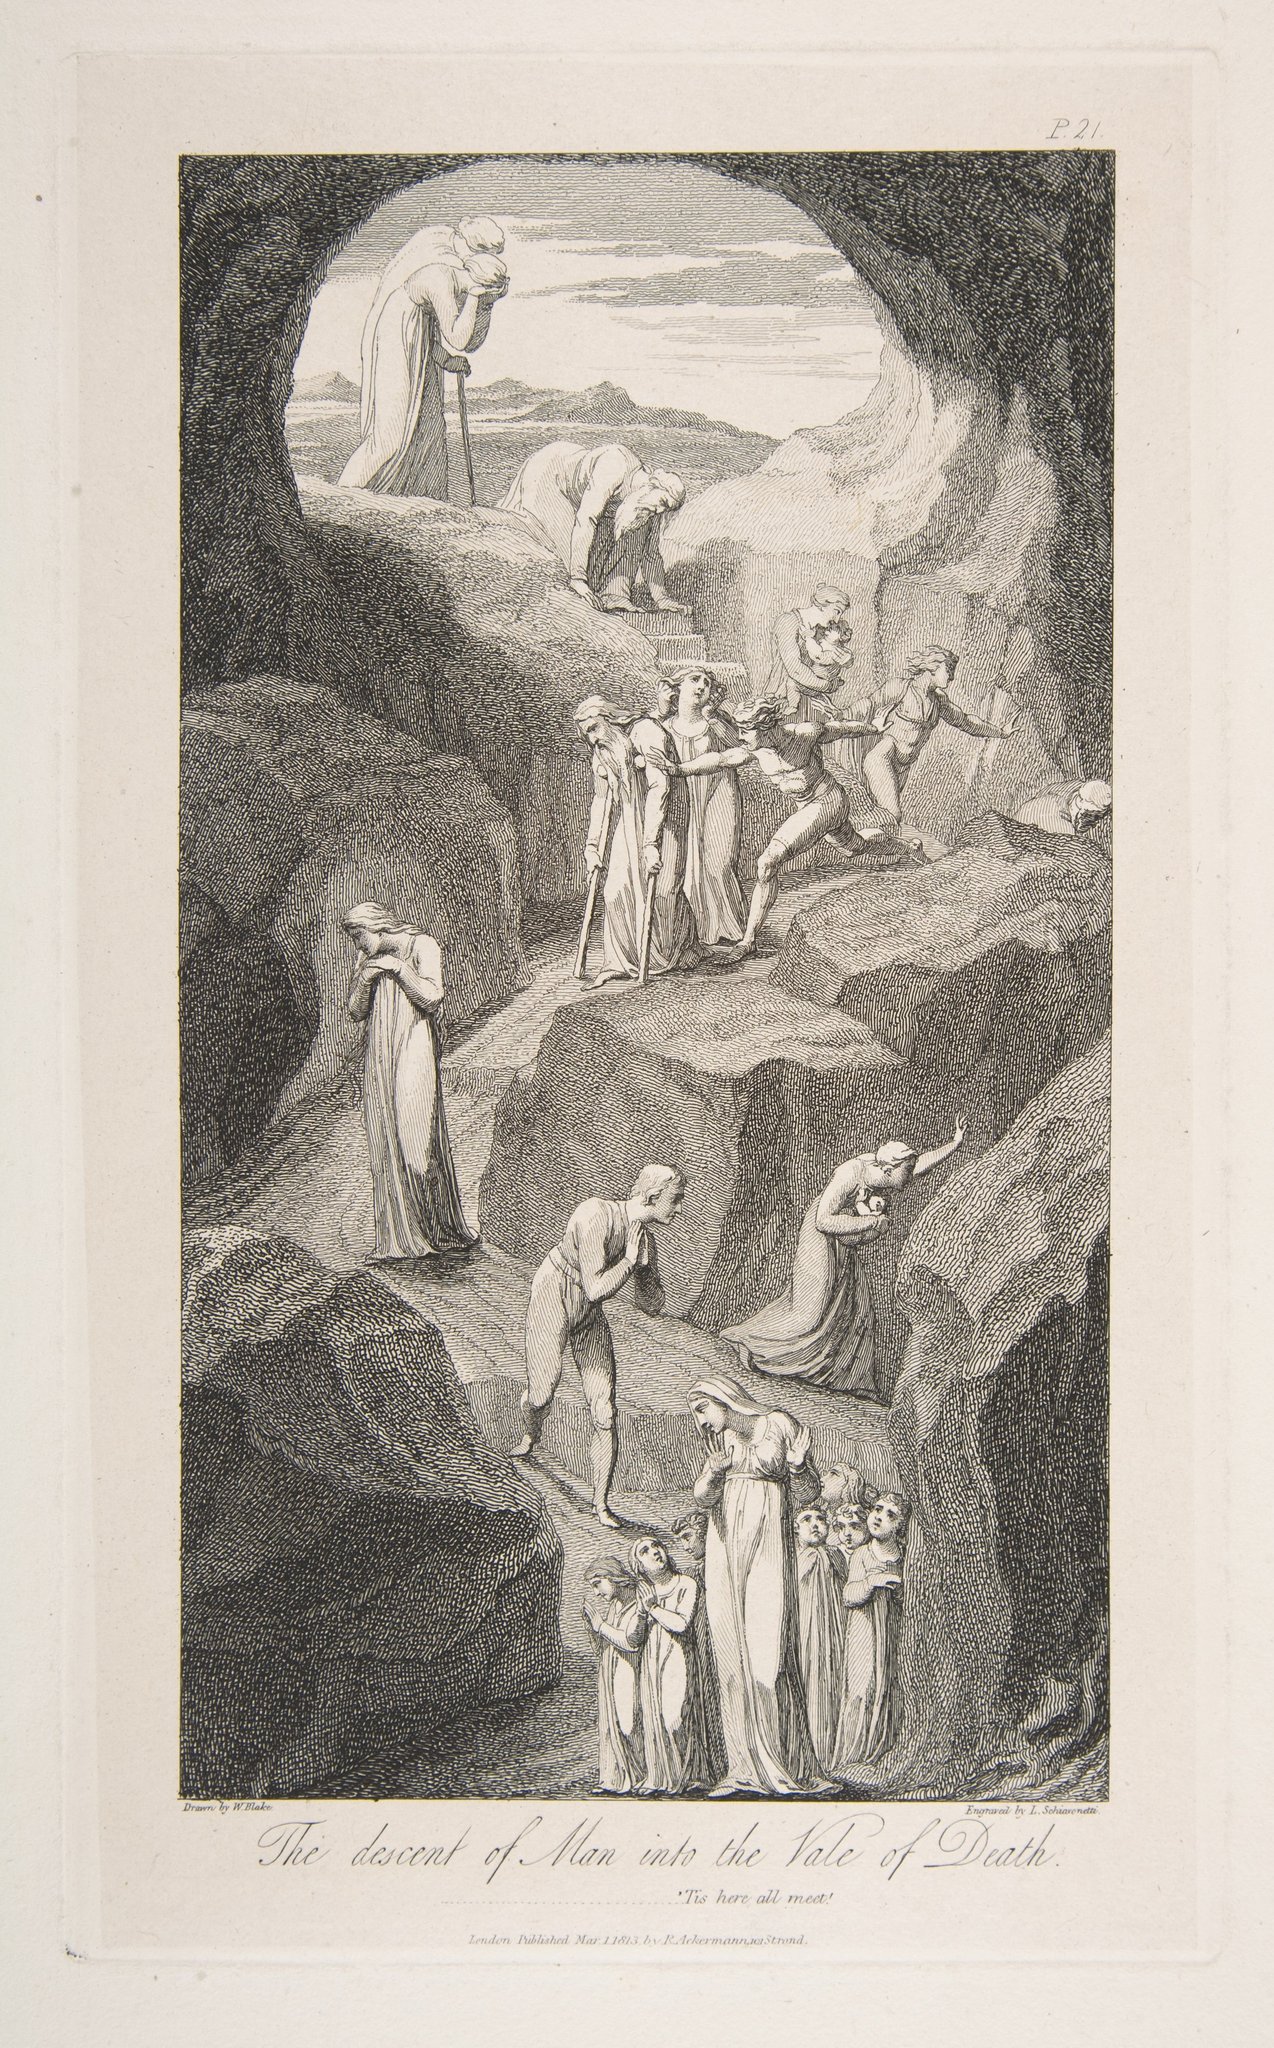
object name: print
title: The Descent of Man into the Vale of Death, from "The Grave," a Poem by Robert Blair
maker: william blake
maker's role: artist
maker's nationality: british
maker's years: 1757-1827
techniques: engraving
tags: children,men,women